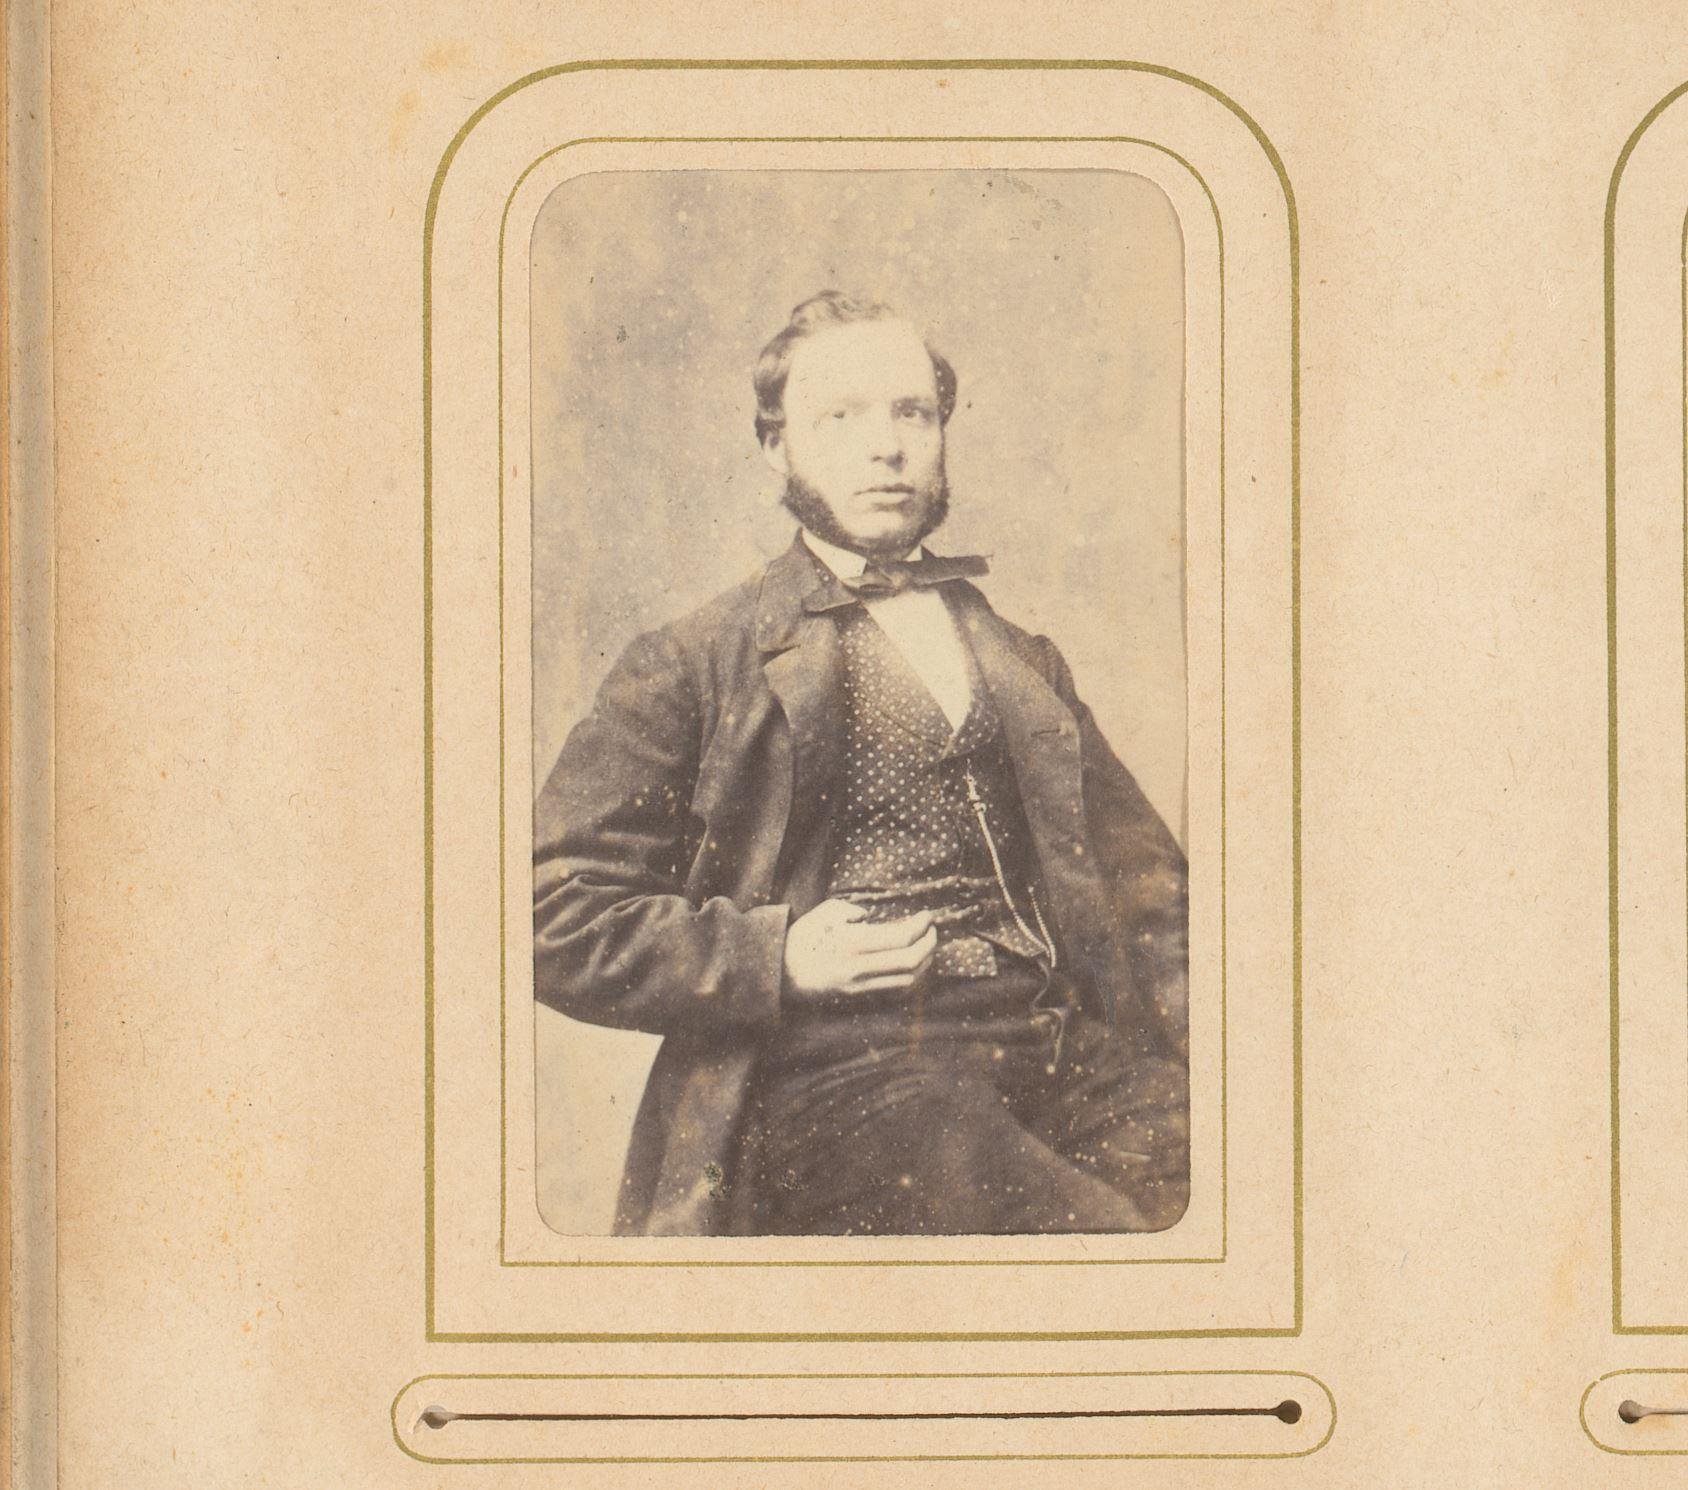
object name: album leaf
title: Portret van een zittende man met bakkebaarden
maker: kasparus karsen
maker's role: draughtsman, painter, print maker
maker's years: 1810-1896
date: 1850-1896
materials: cardboard, photographic support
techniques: albumen print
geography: amsterdam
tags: sideburns, sitting figure, historical persons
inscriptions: inscription: ‘Photographie/ K. KARSEN/ Kunstschilder en Photograa[f]/ AMSTERDAM/ Nieuwendyk H. No. 4.’